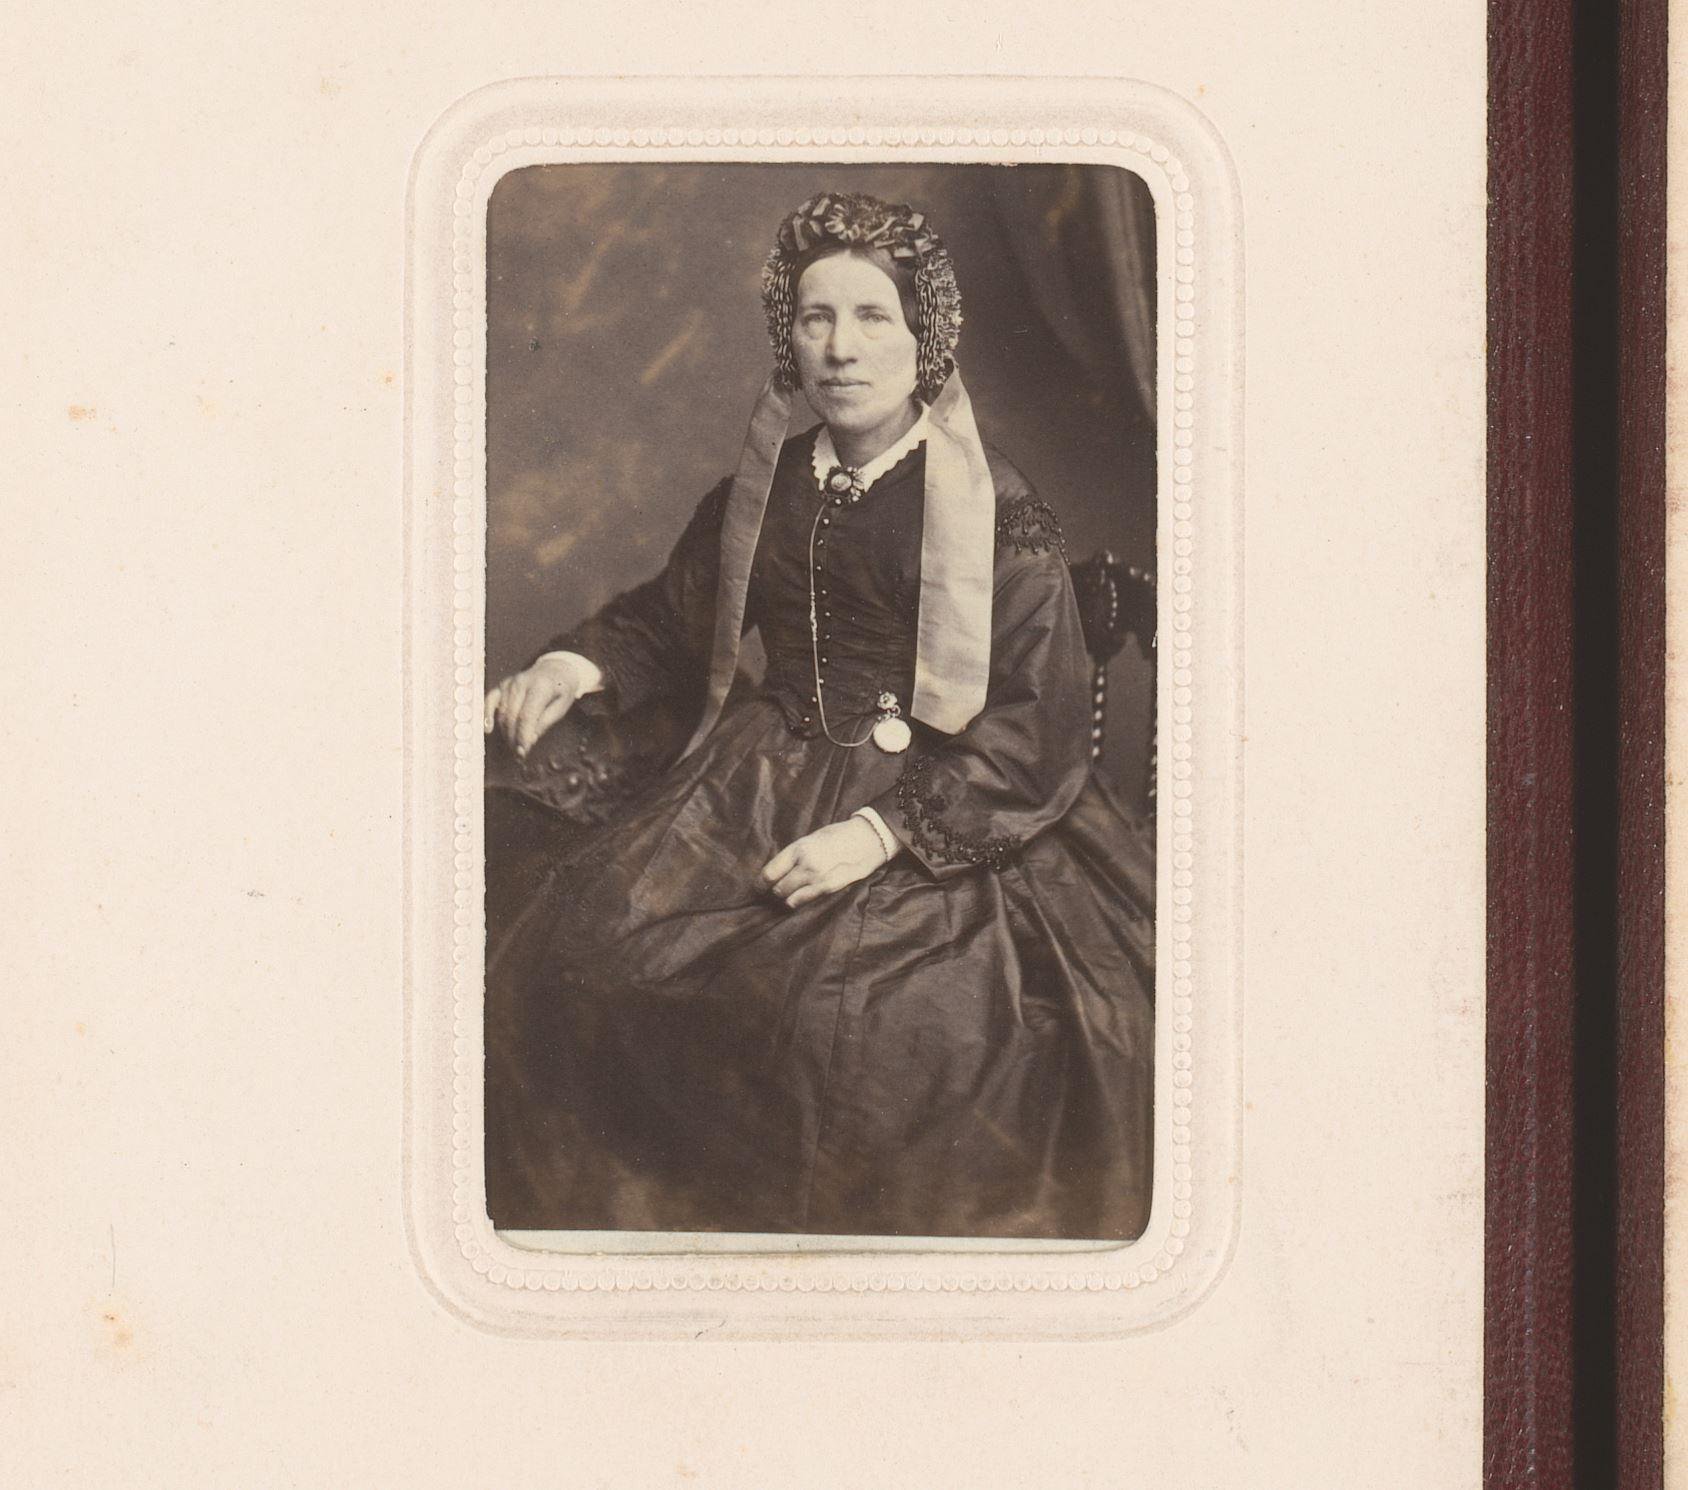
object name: carte de visite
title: Portret van een zittende vrouw met muts met linten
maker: carl rensing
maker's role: fotograaf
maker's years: 1826-1898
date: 1856-1870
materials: cardboard, paper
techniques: albumen print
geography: amsterdam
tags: sitting figure - aa - female human figure, historical persons - bb - woman, head-gear: cap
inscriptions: inscription: ‘Amsterdam’